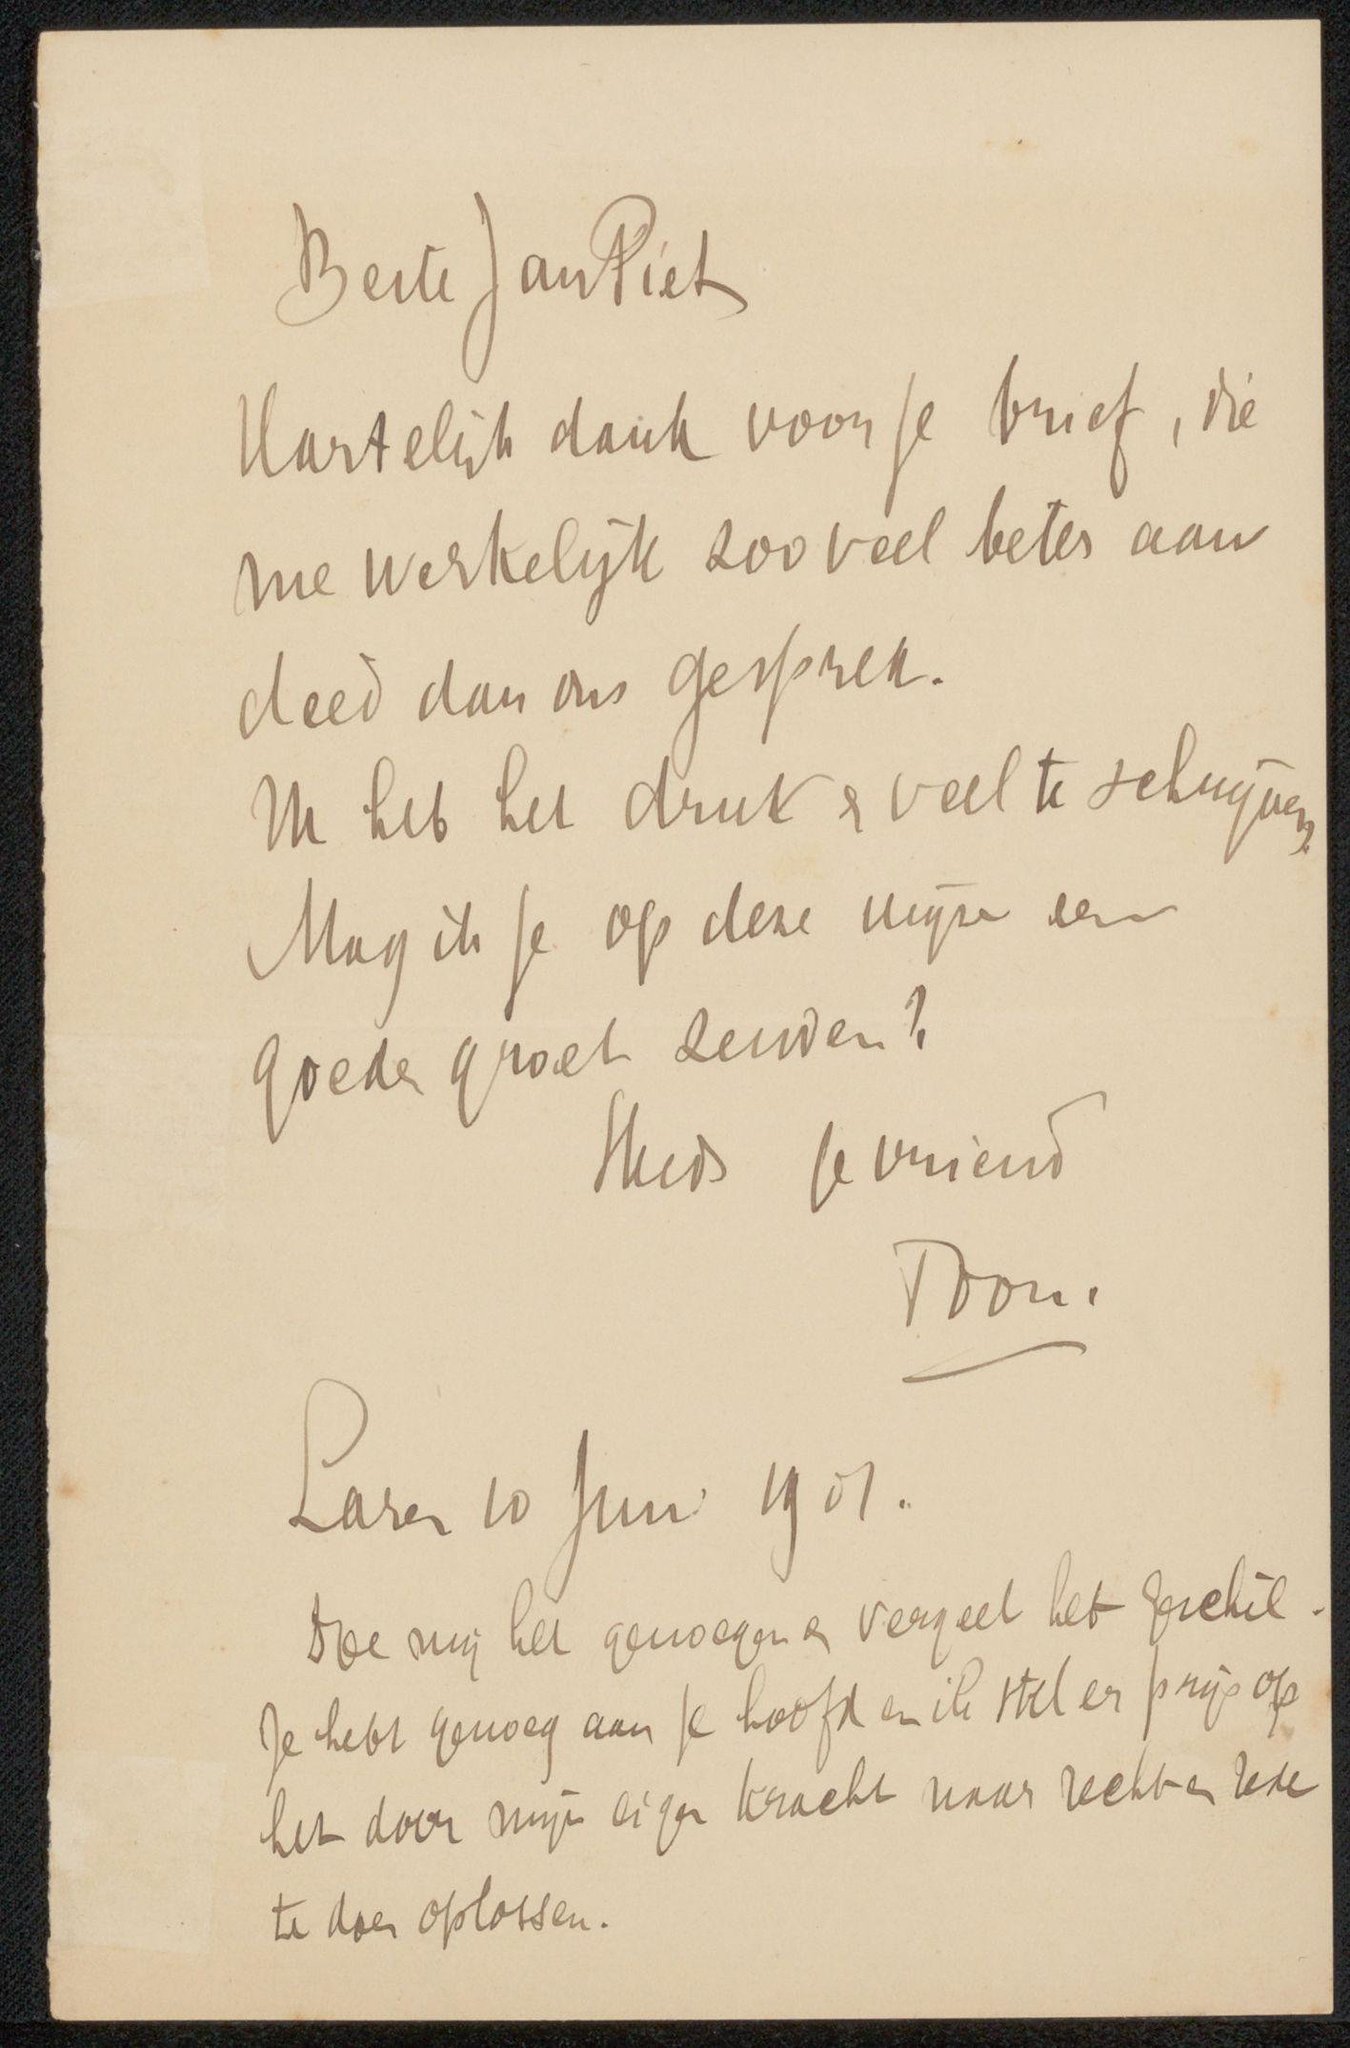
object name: letter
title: Brief aan Jan Veth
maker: antoon derkinderen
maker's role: draughtsman, painter, print maker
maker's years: 1859-1925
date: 1901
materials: ink, paper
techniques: pen, writing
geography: laren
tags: dordrecht, painter, print maker, draughtsman, designer, jan veth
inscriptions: collector's mark: ‘RPK’